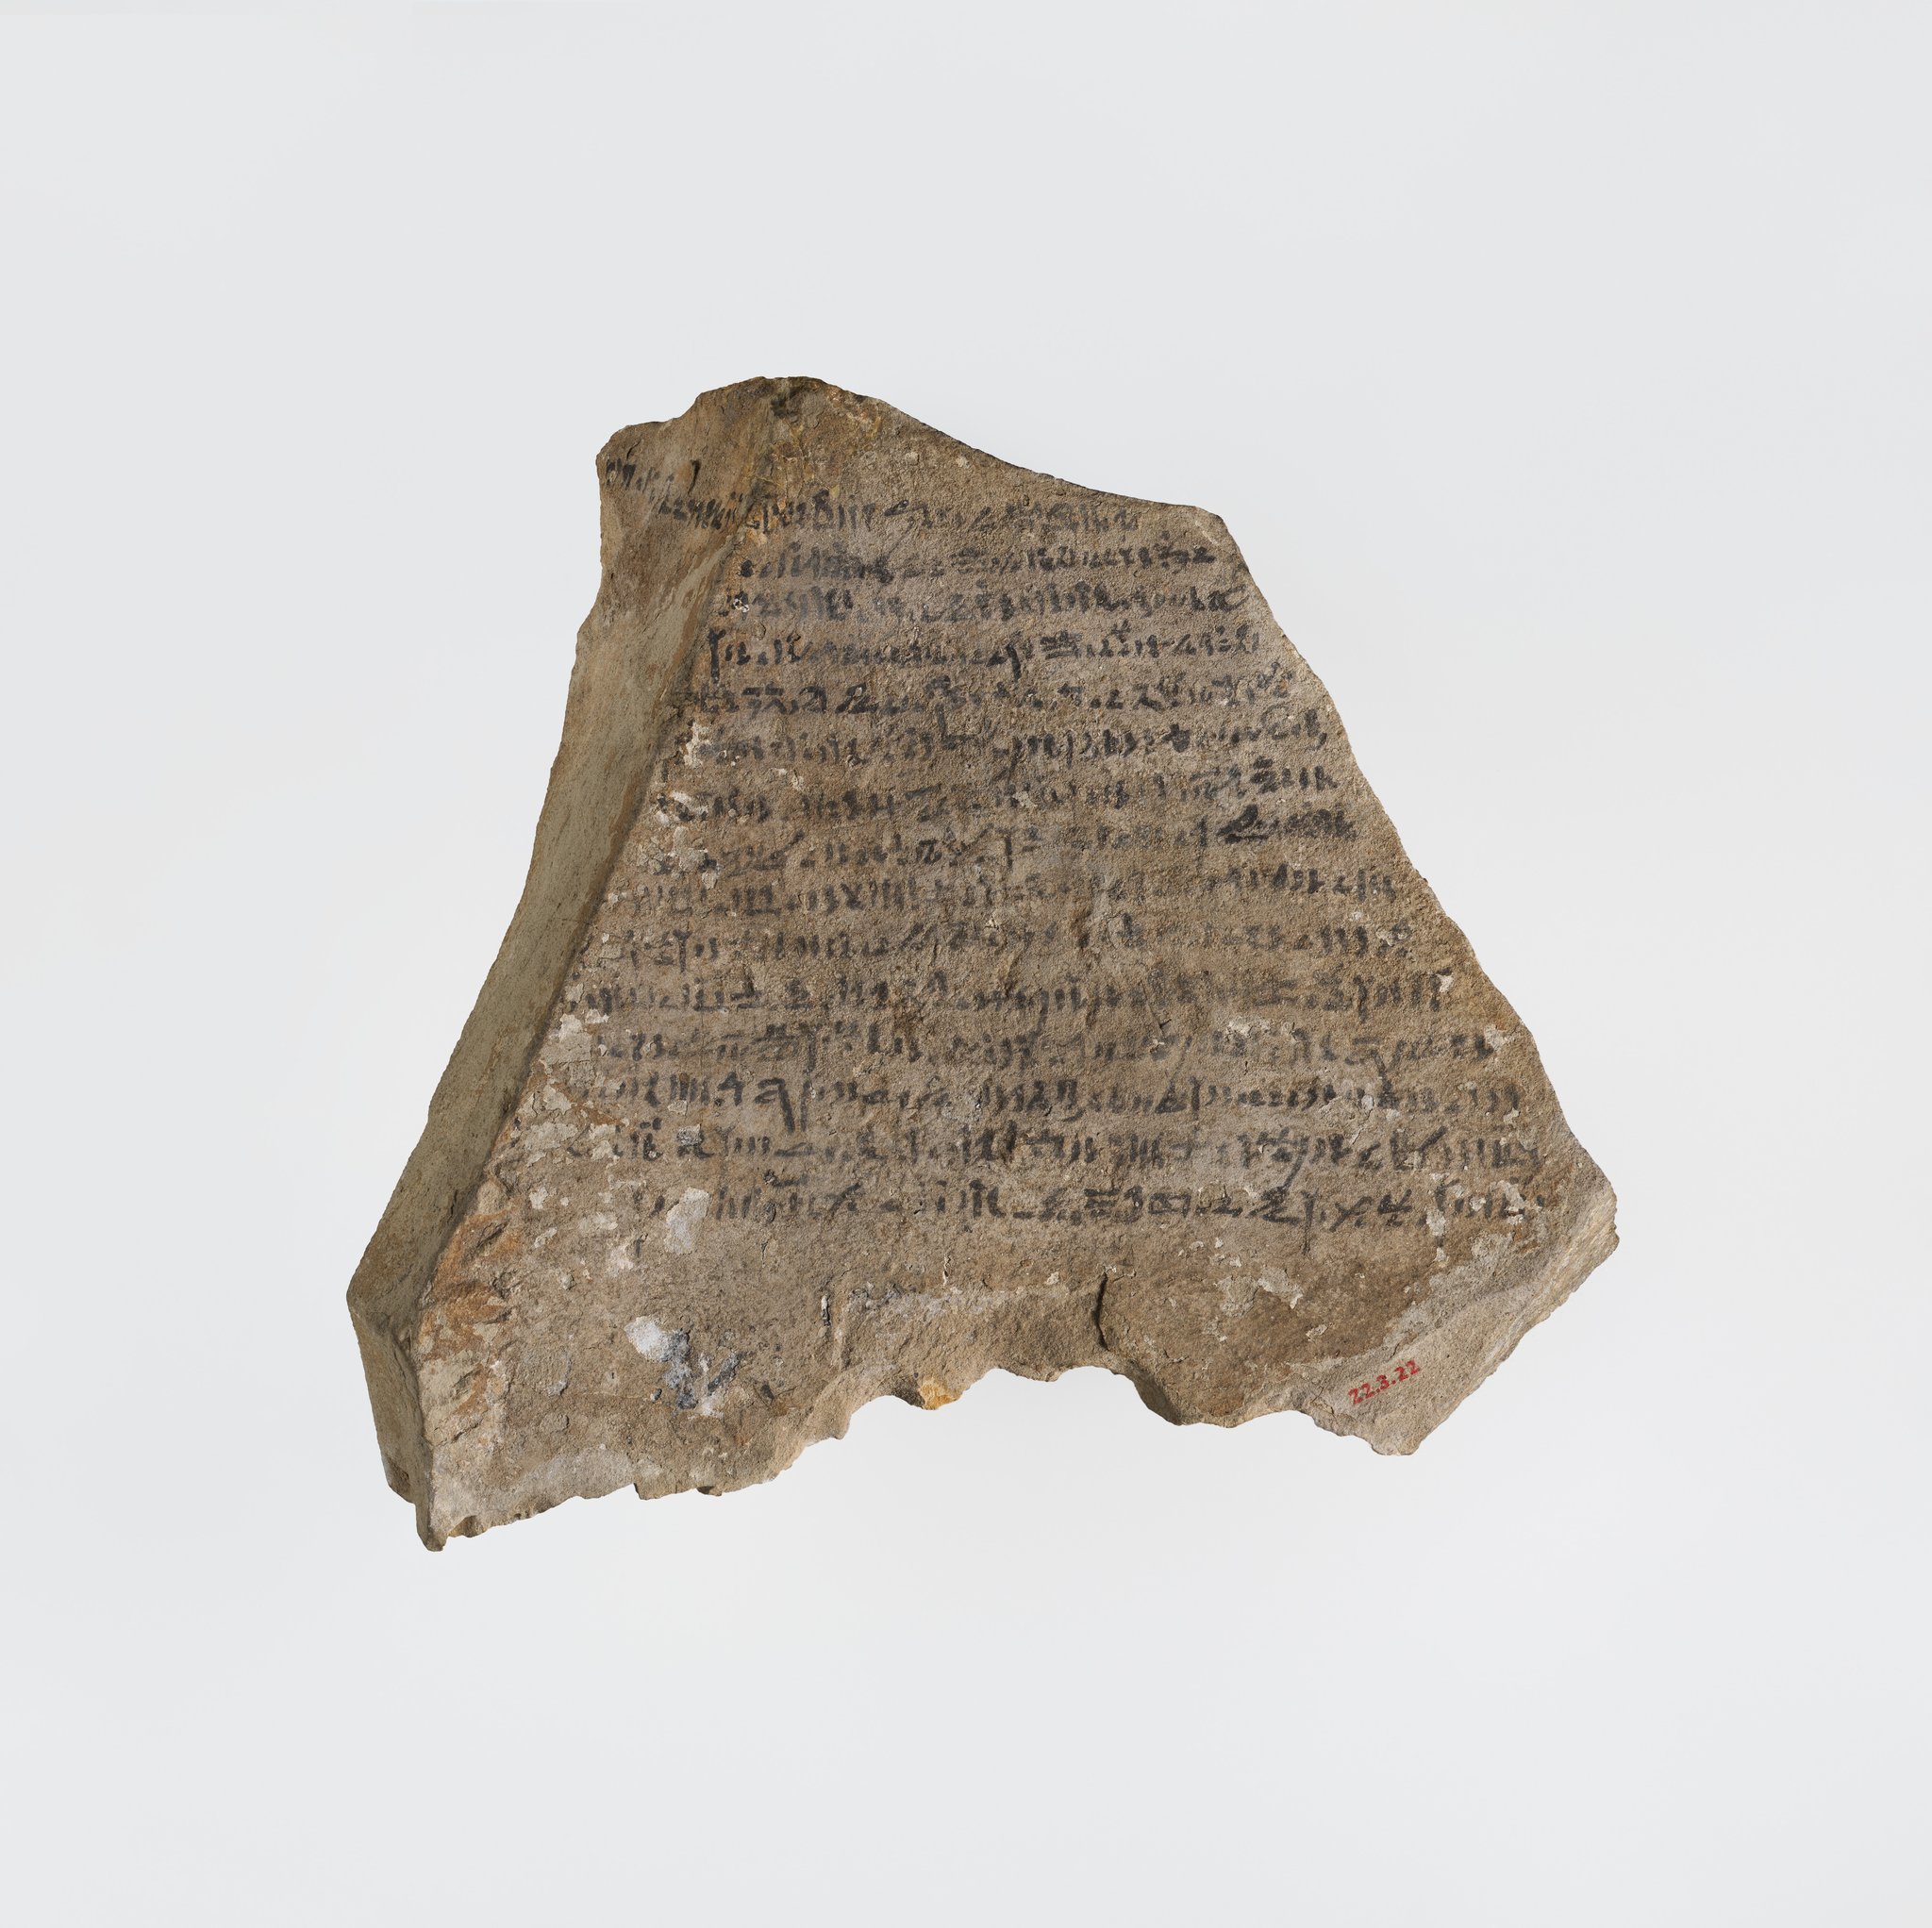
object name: ostracon, hieratic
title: Ostracon with hieratic inscription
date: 1295-525 BCE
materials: ink, limestone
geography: egypt